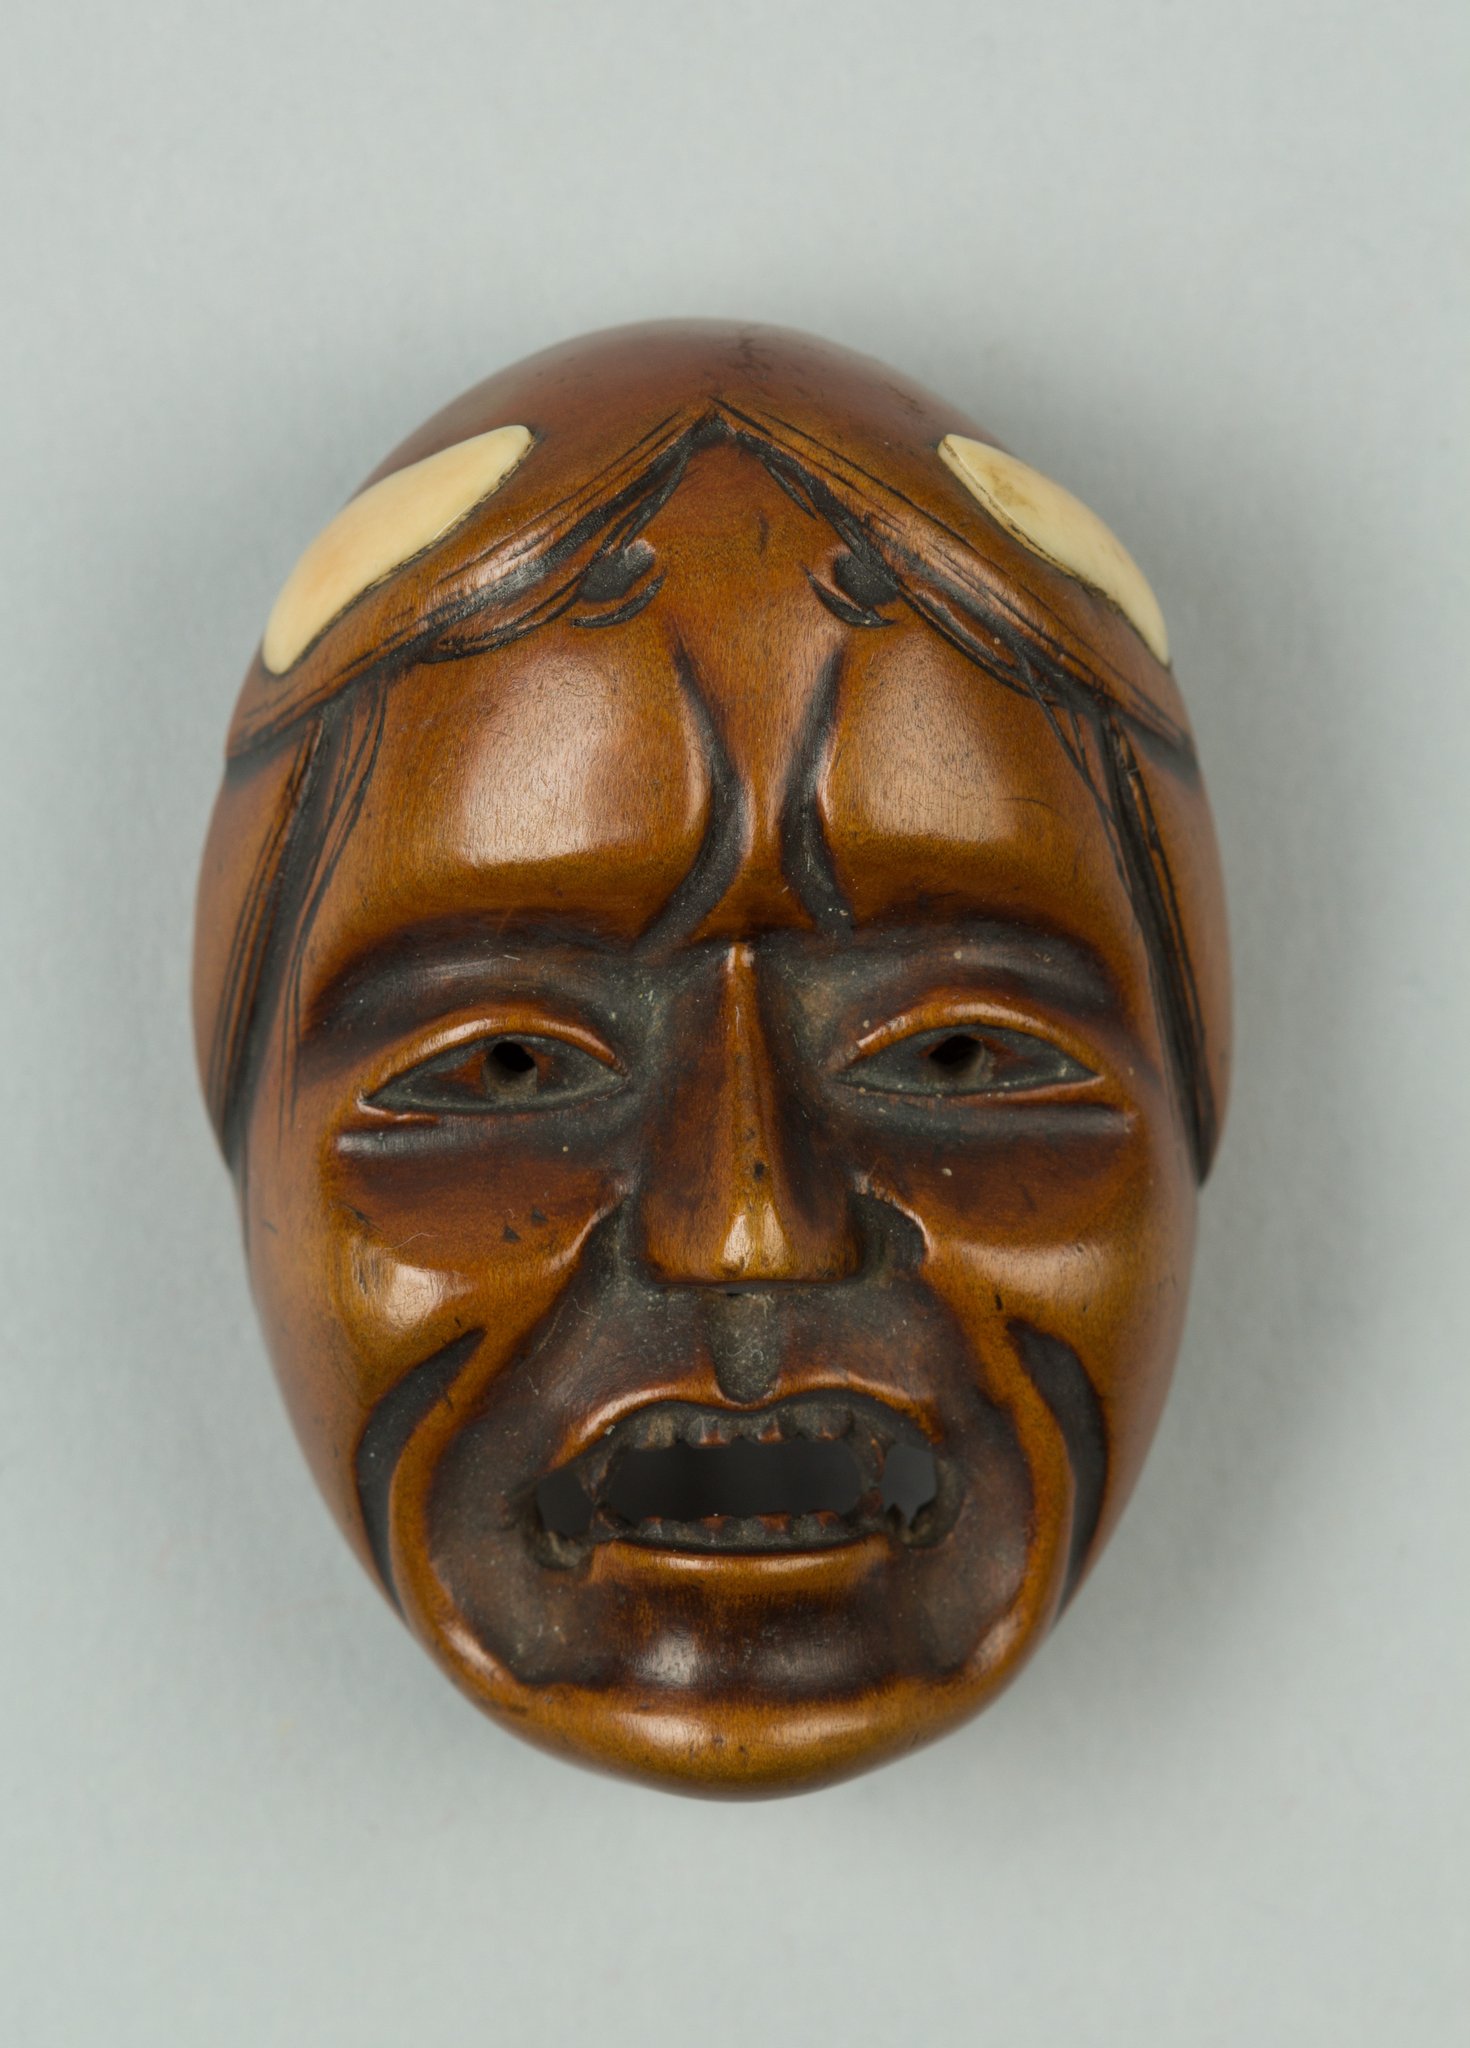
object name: netsuke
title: Netsuke of Woman's Face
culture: japanese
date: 1801-1900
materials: hair, ivory, wood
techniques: inlay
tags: faces,women